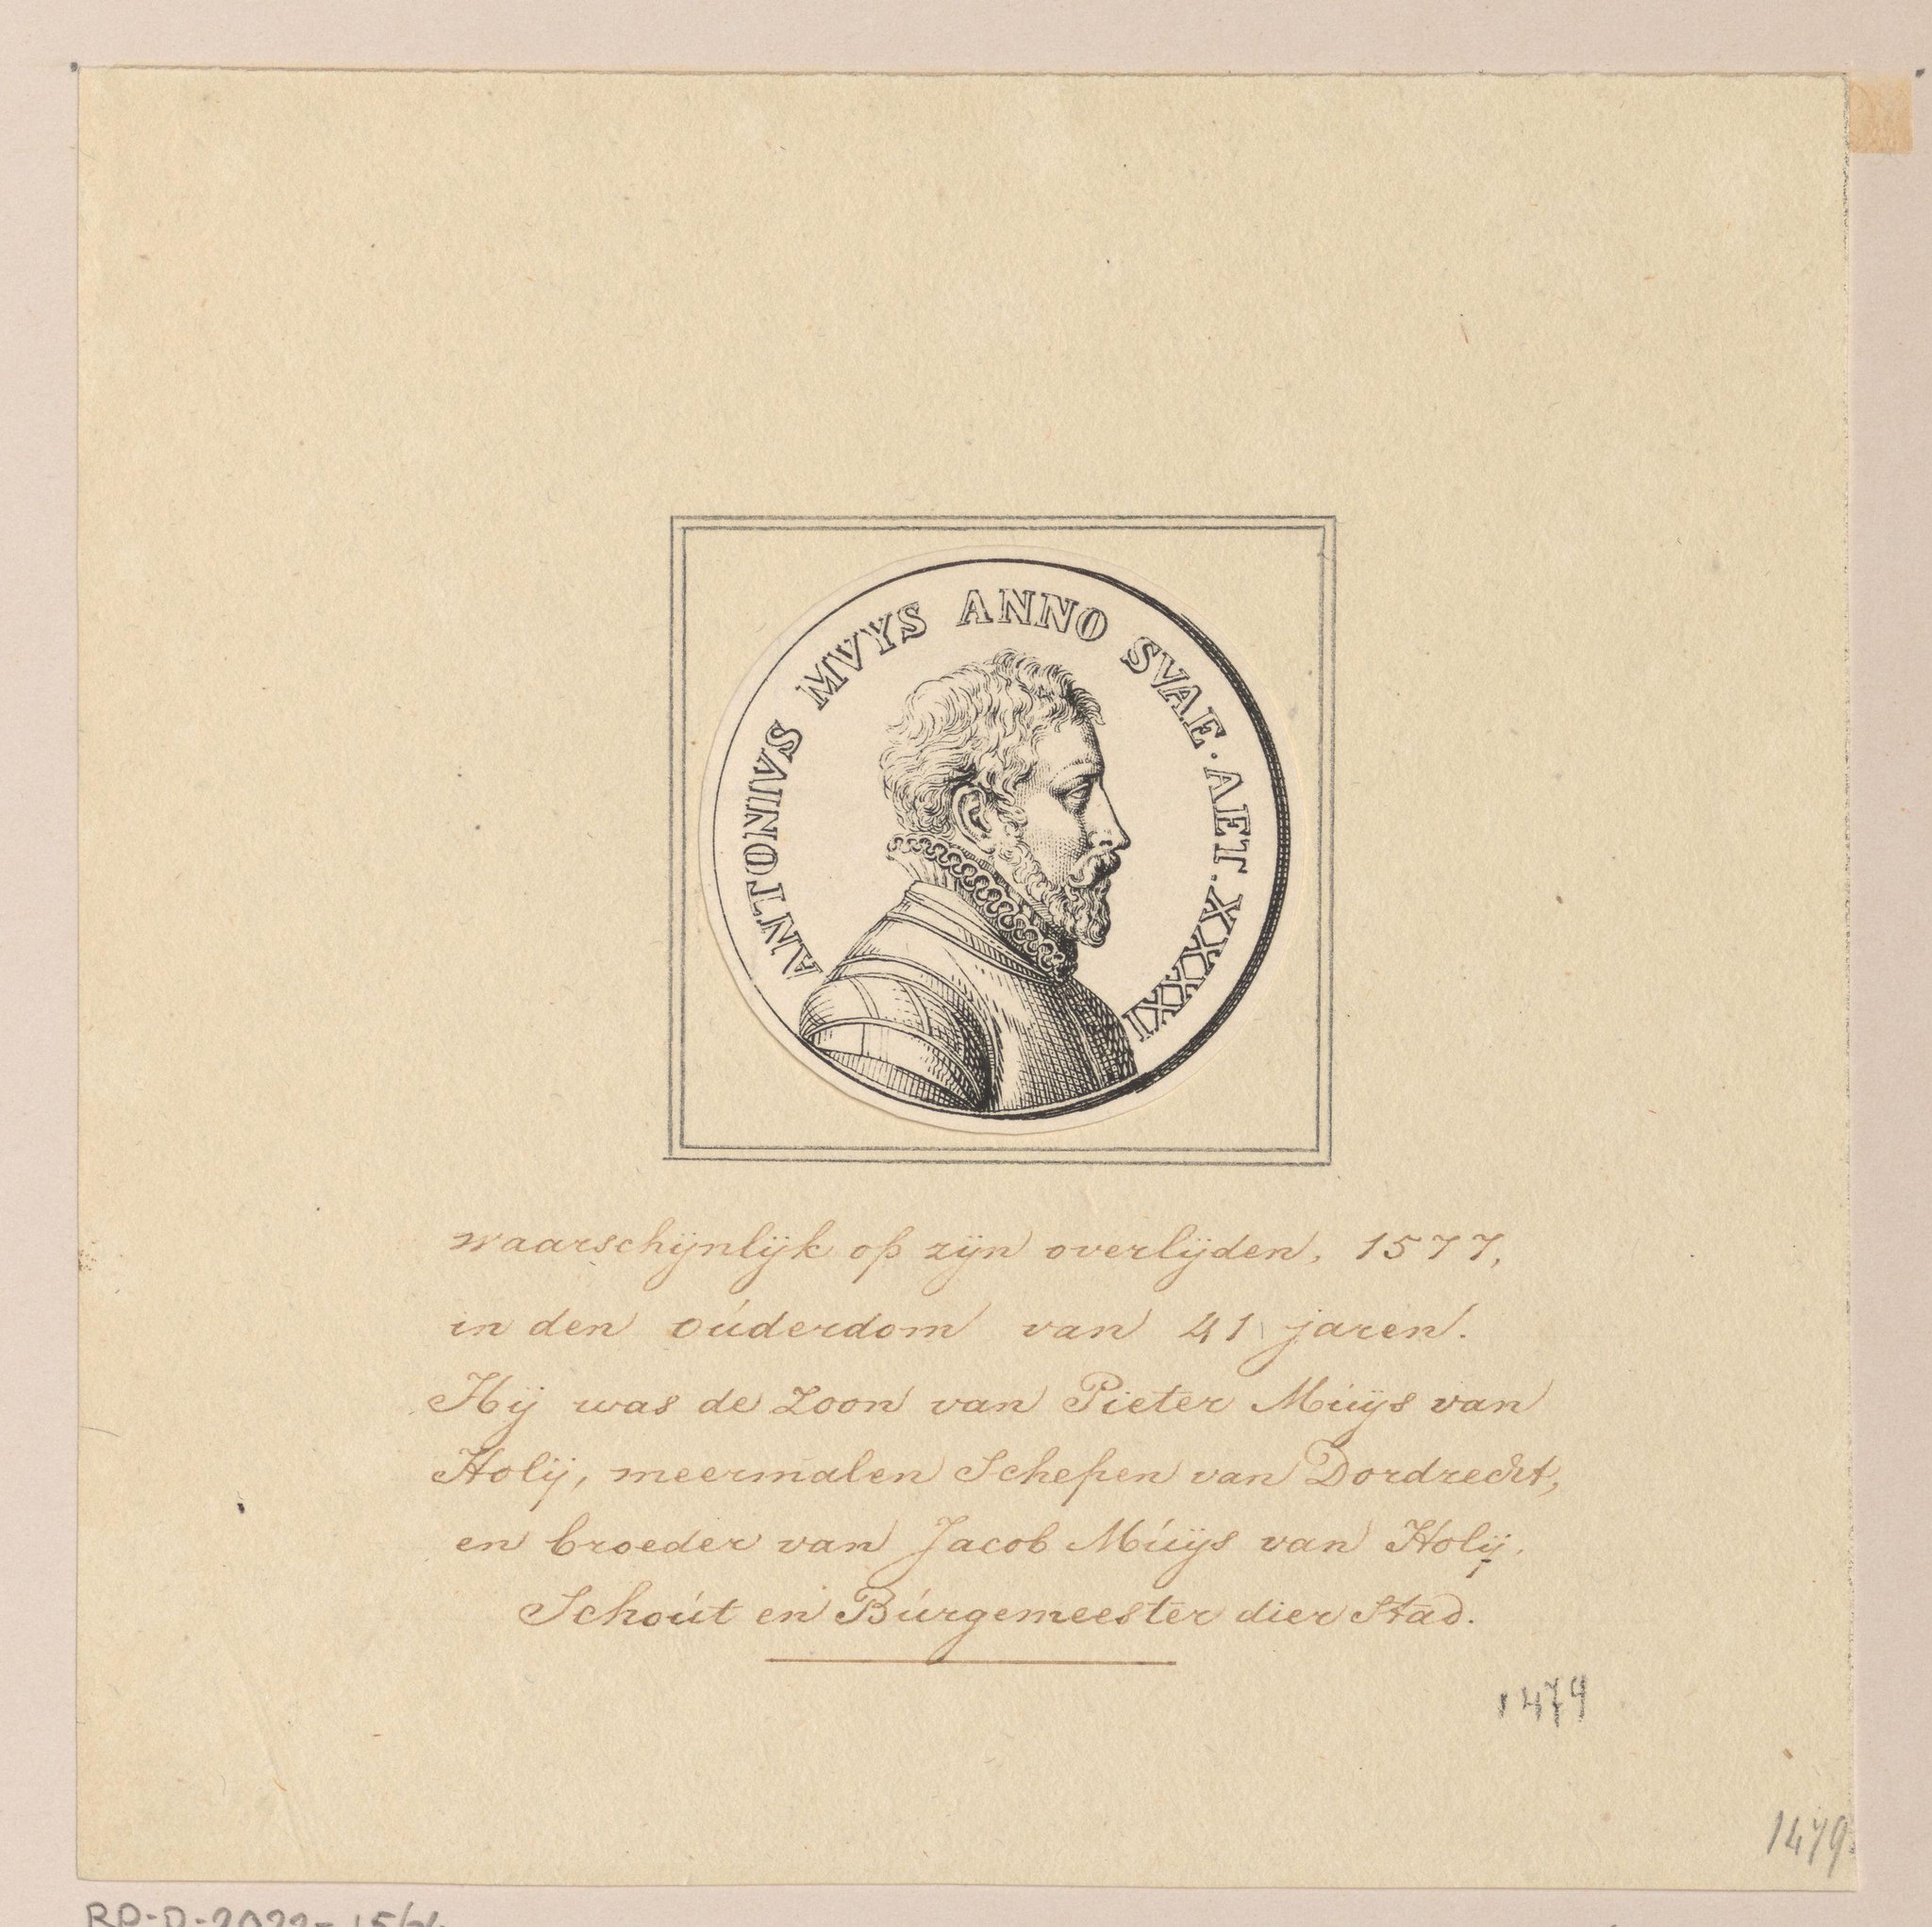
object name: print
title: Voorzijde van een penning met het portret van Antonius Muys van Holy op 41-jarige leeftijd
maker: Anonymous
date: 1700-1850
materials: ink, paper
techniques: etching, pen, snipping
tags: historical persons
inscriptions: inscription: ‘waarschijnlijk op zijn (...) Burgemeester dier stad.’